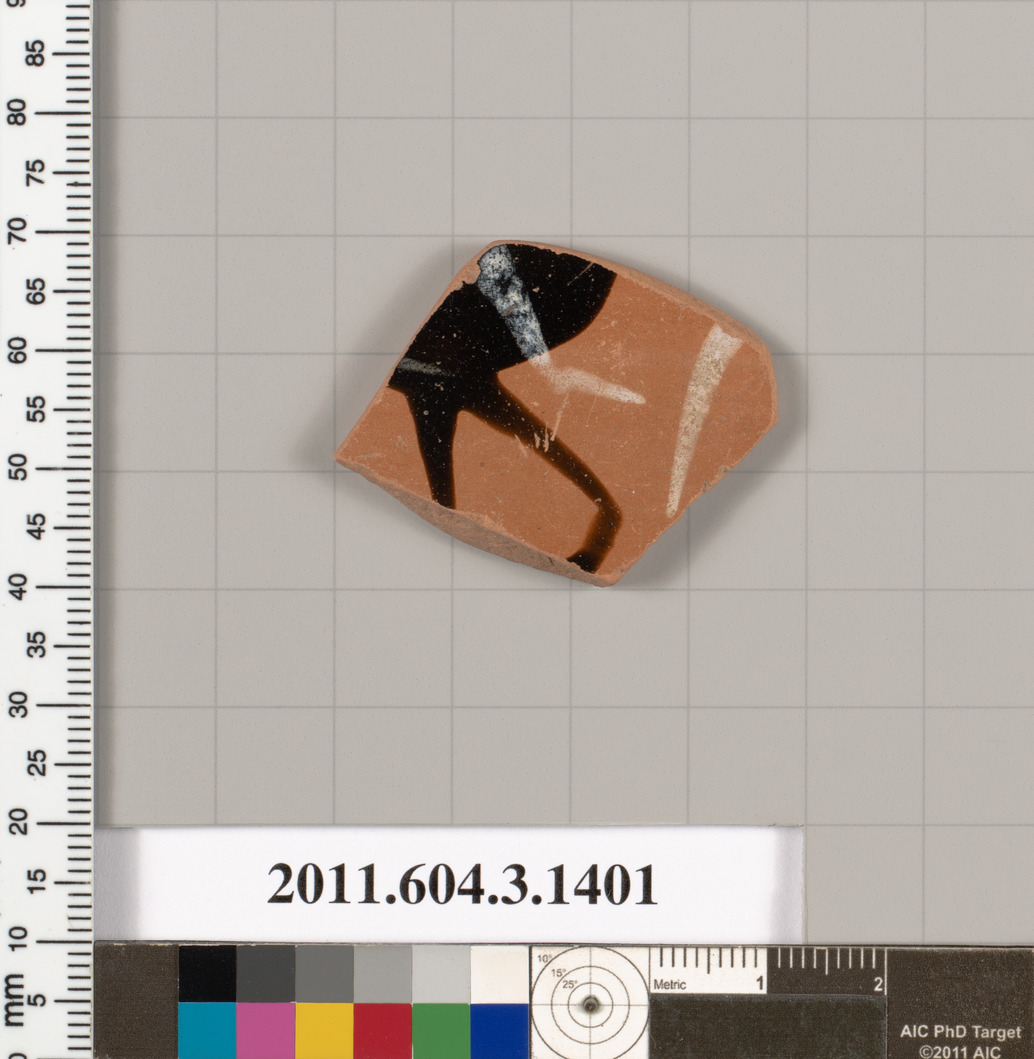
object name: skyphos fragment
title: Terracotta fragment of a skyphos (deep drinking cup)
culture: greek, attic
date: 534-468 BCE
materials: terracotta